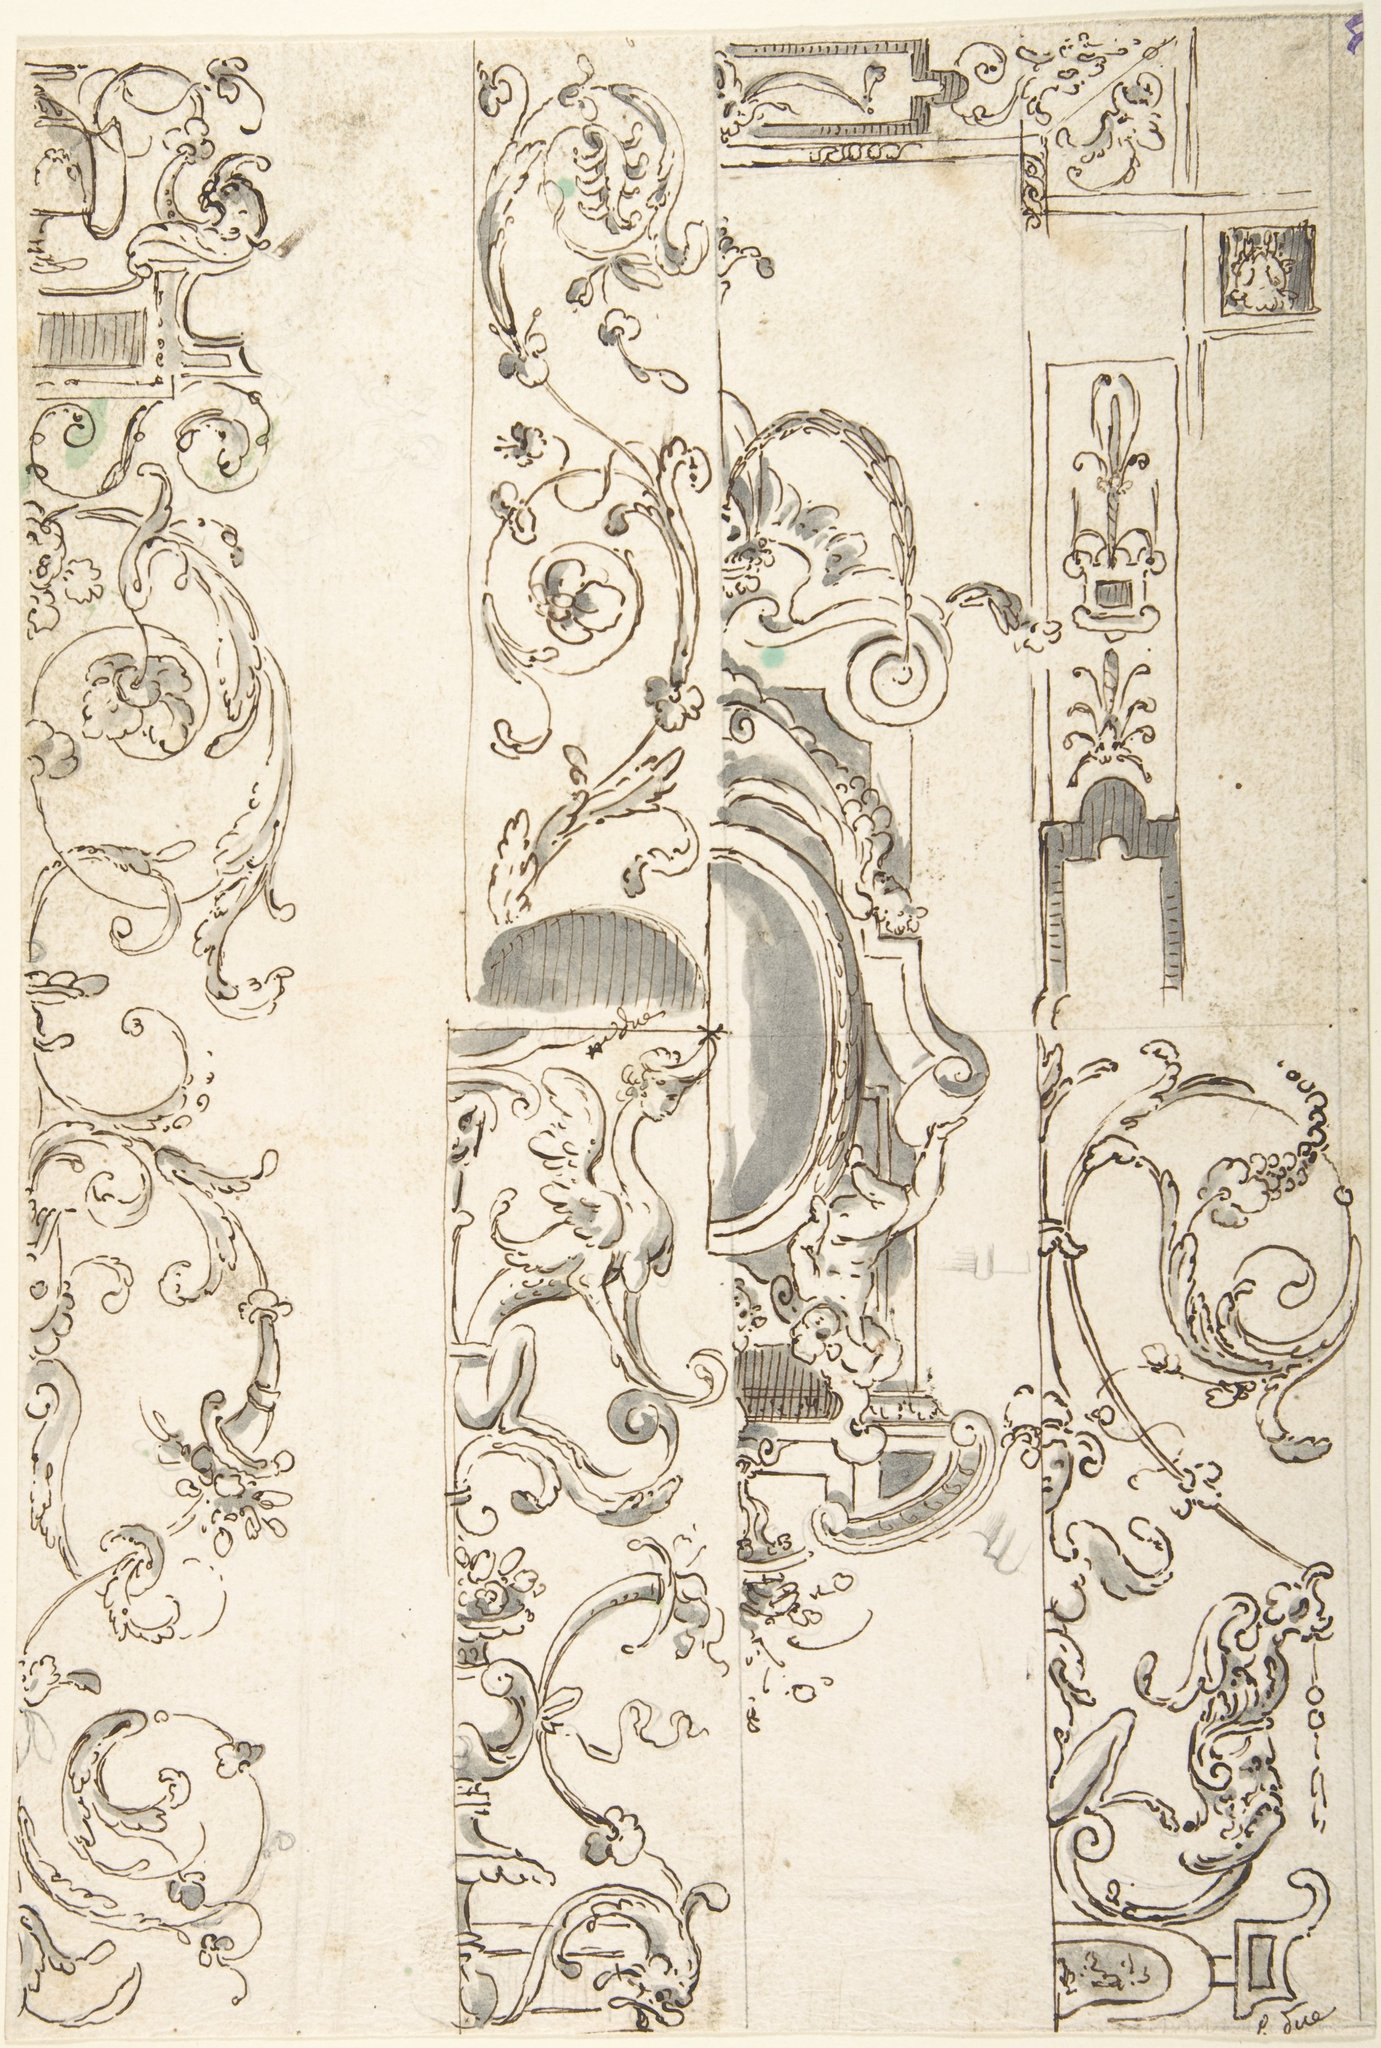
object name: drawing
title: Sheet with Various Studies of Candelabra Grotesques, Foliage and a Cartouche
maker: anonymous, italian, 16th to 17th century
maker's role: artist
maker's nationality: italian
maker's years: 1500-1700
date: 1500-1700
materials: ink, drawing material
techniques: brush, pen, wash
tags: grotesques,ornament